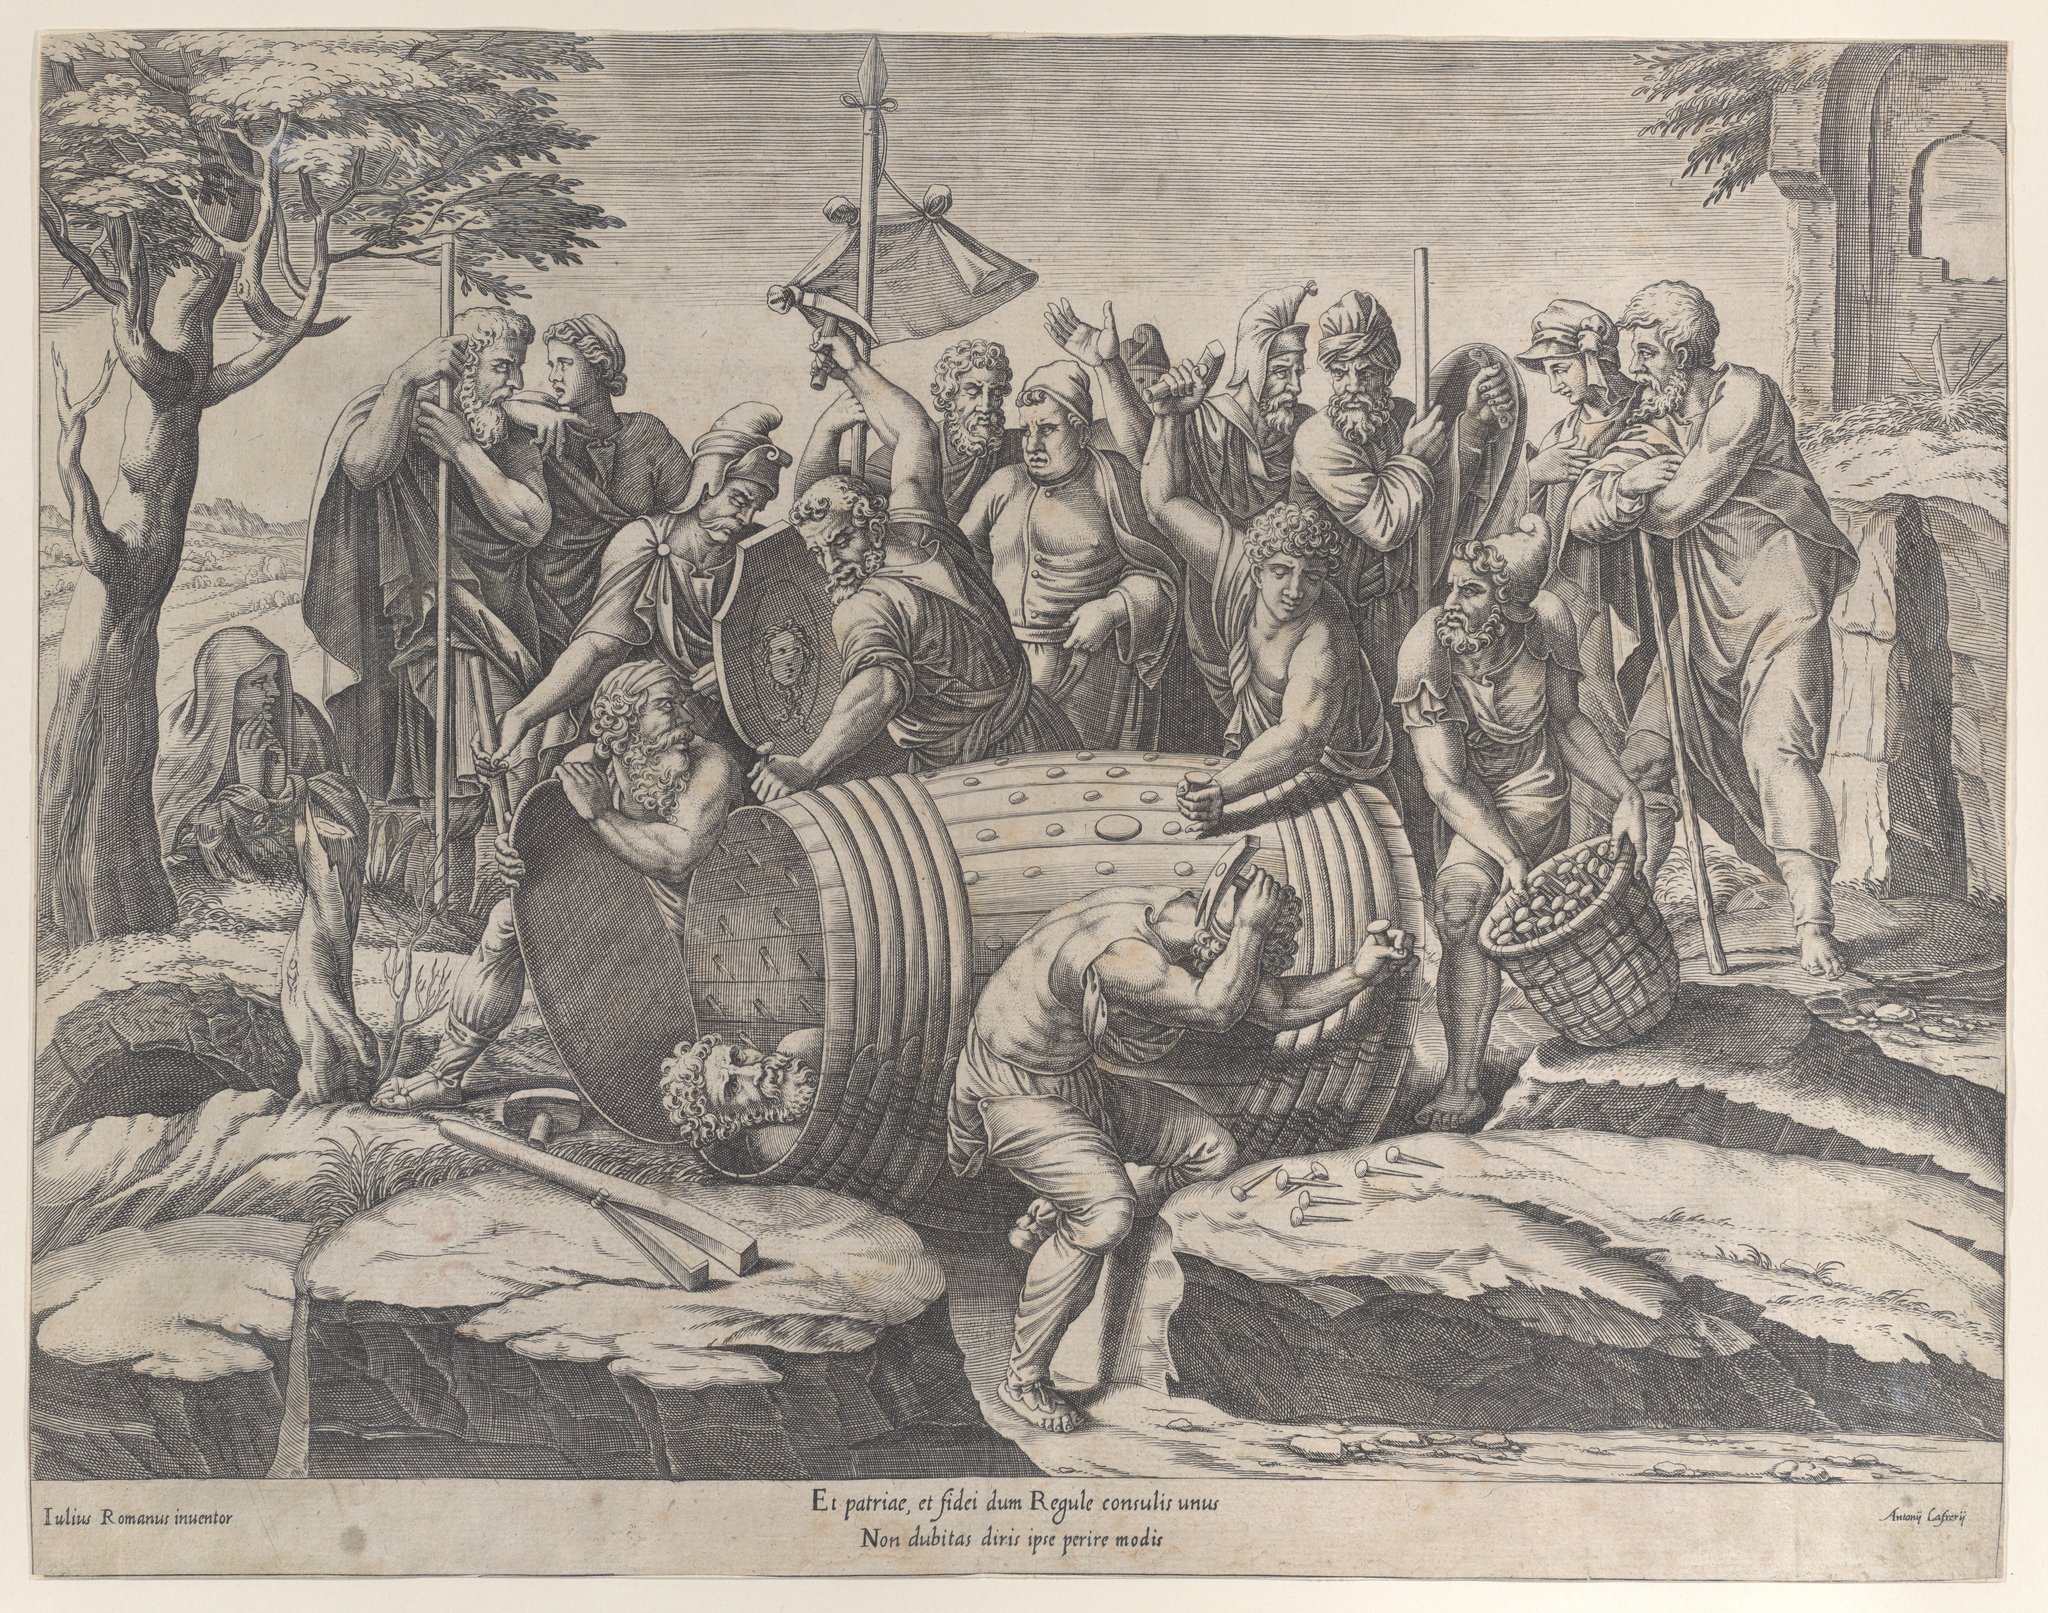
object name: print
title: Marcus Atilius Regulus in a barrel while two men are hammering in the nails, various figures throughout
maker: diana scultori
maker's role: artist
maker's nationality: italian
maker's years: 1535-1588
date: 1555-1577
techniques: engraving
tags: men,hammers,barrels